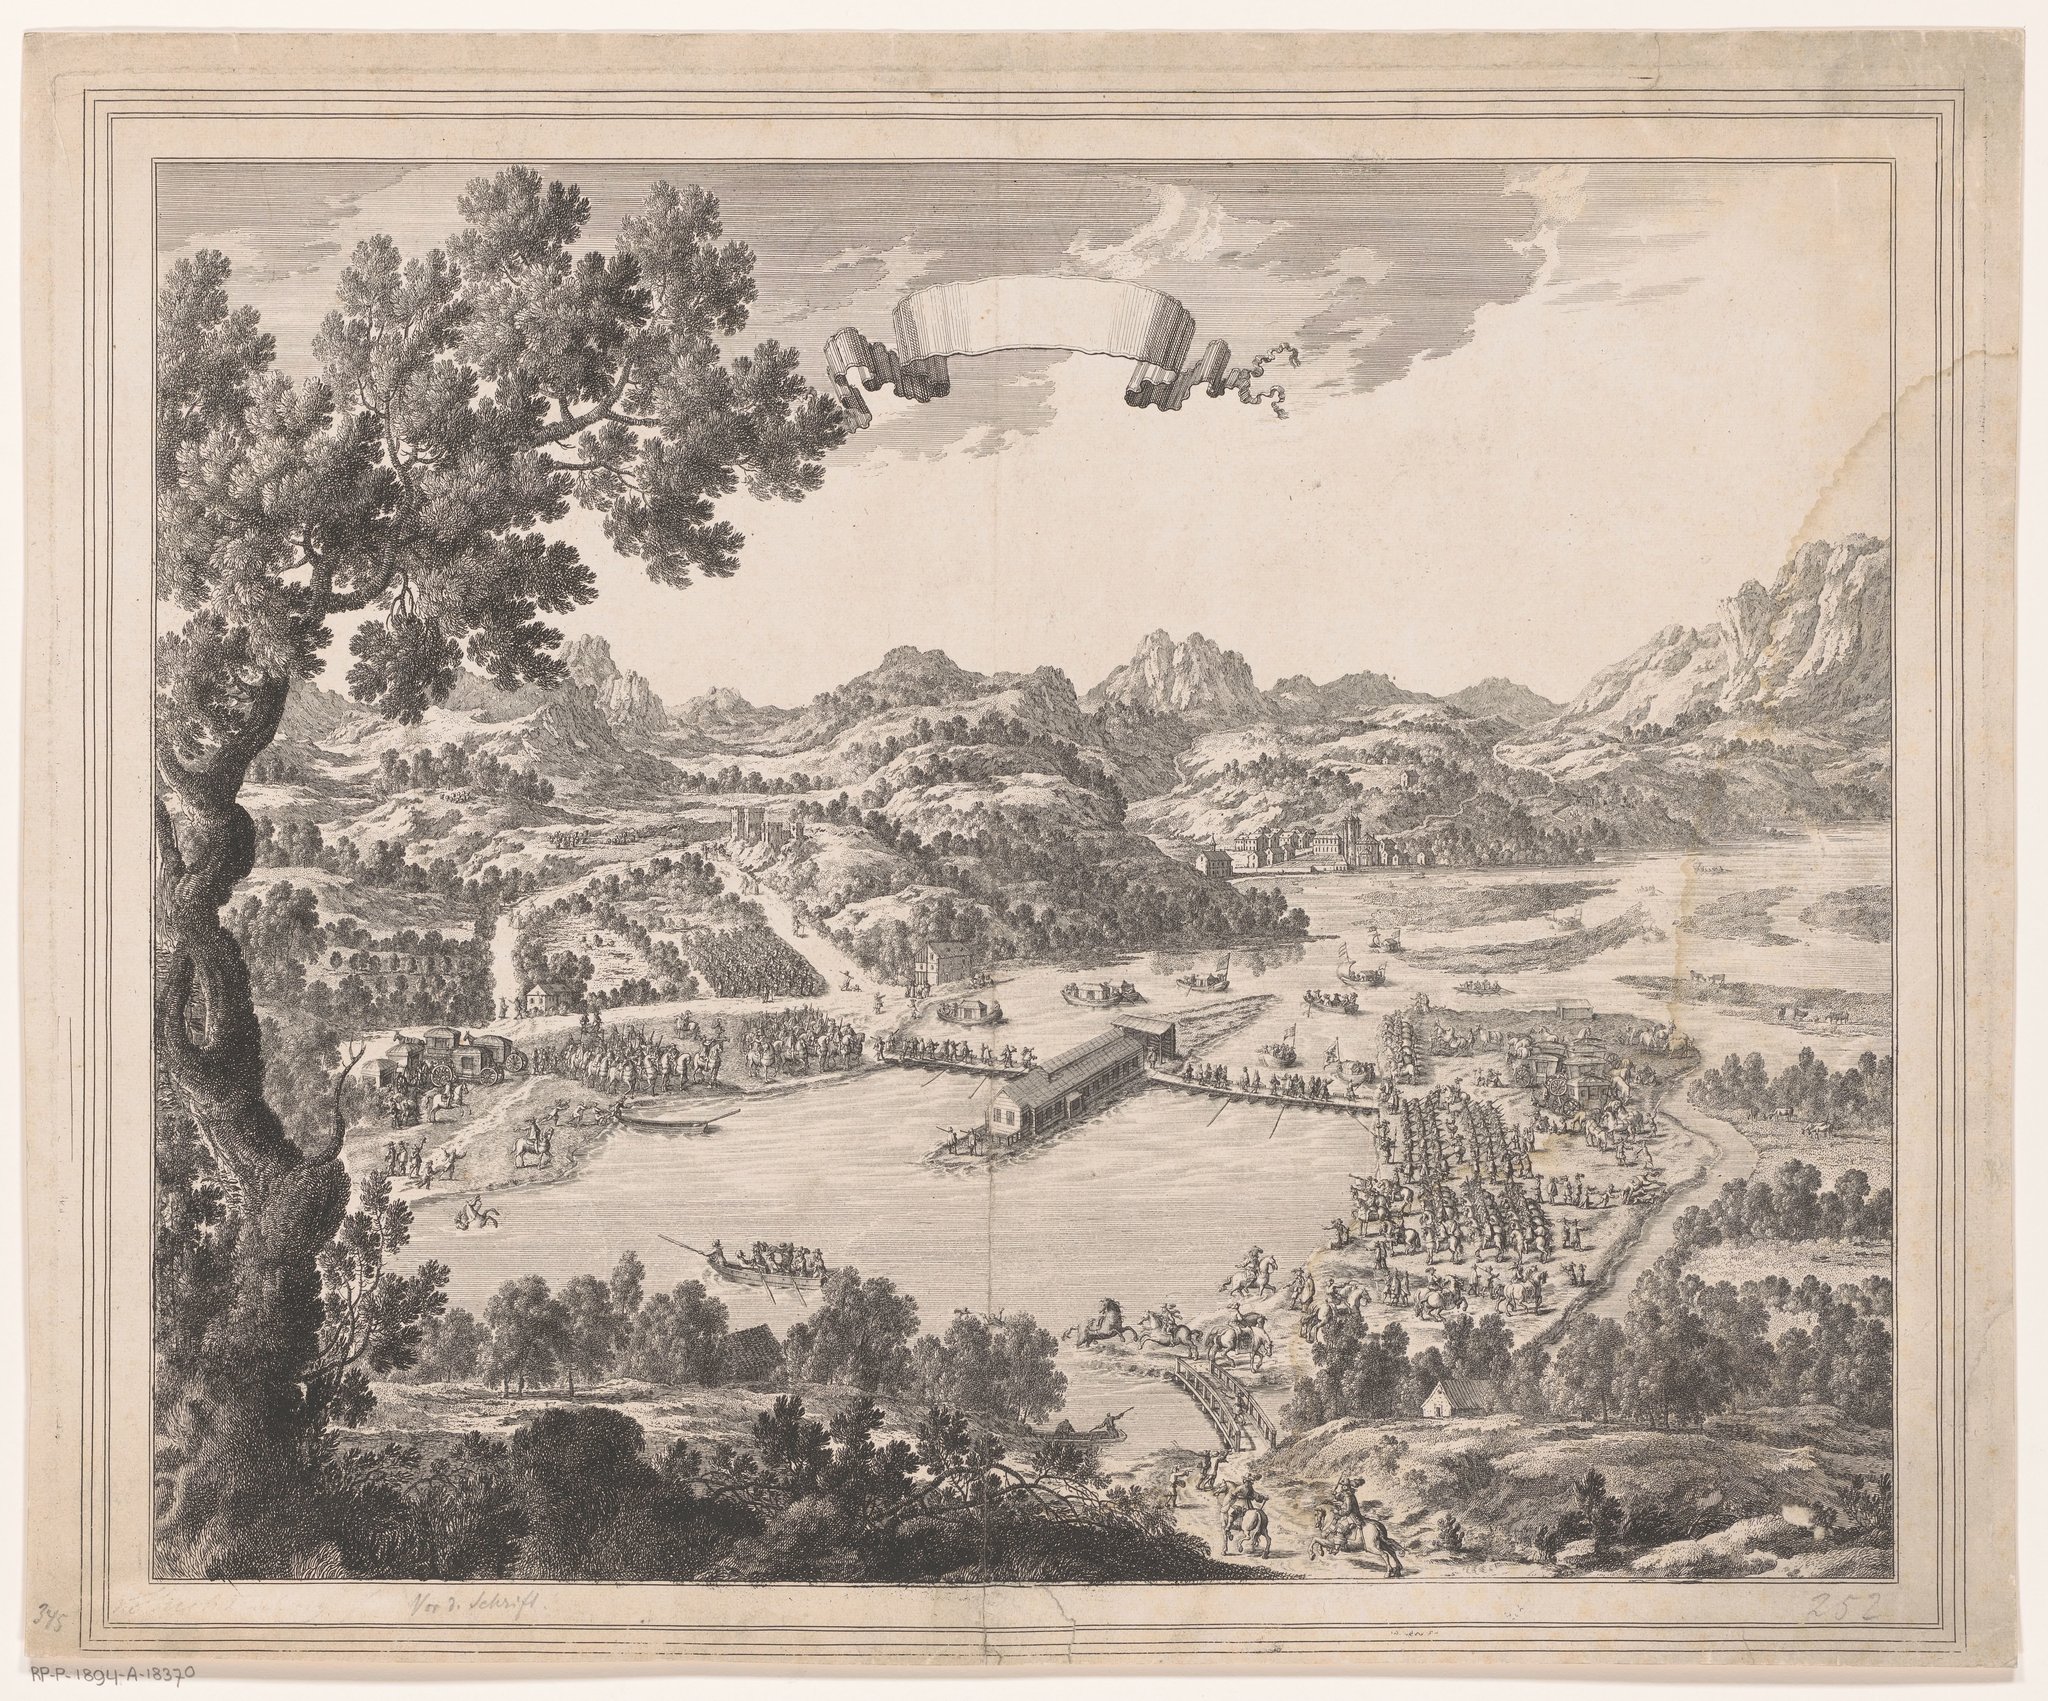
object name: print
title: Vredesconferentie op Île des Faisans met de koningen Lodewijk XIV en Filips IV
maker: adam perelle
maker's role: draughtsman, print maker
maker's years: 1638-1695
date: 1659-1695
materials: paper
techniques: etching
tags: filips iv (koning van spanje), lodewijk xiv (koning van frankrijk), peace negotiations, king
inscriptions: collector's mark: Lugt 2228, collector's mark: Lugt 1114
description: Aan weerszijden van de rivier arriveren de koningen met hun legers en hofhouding.